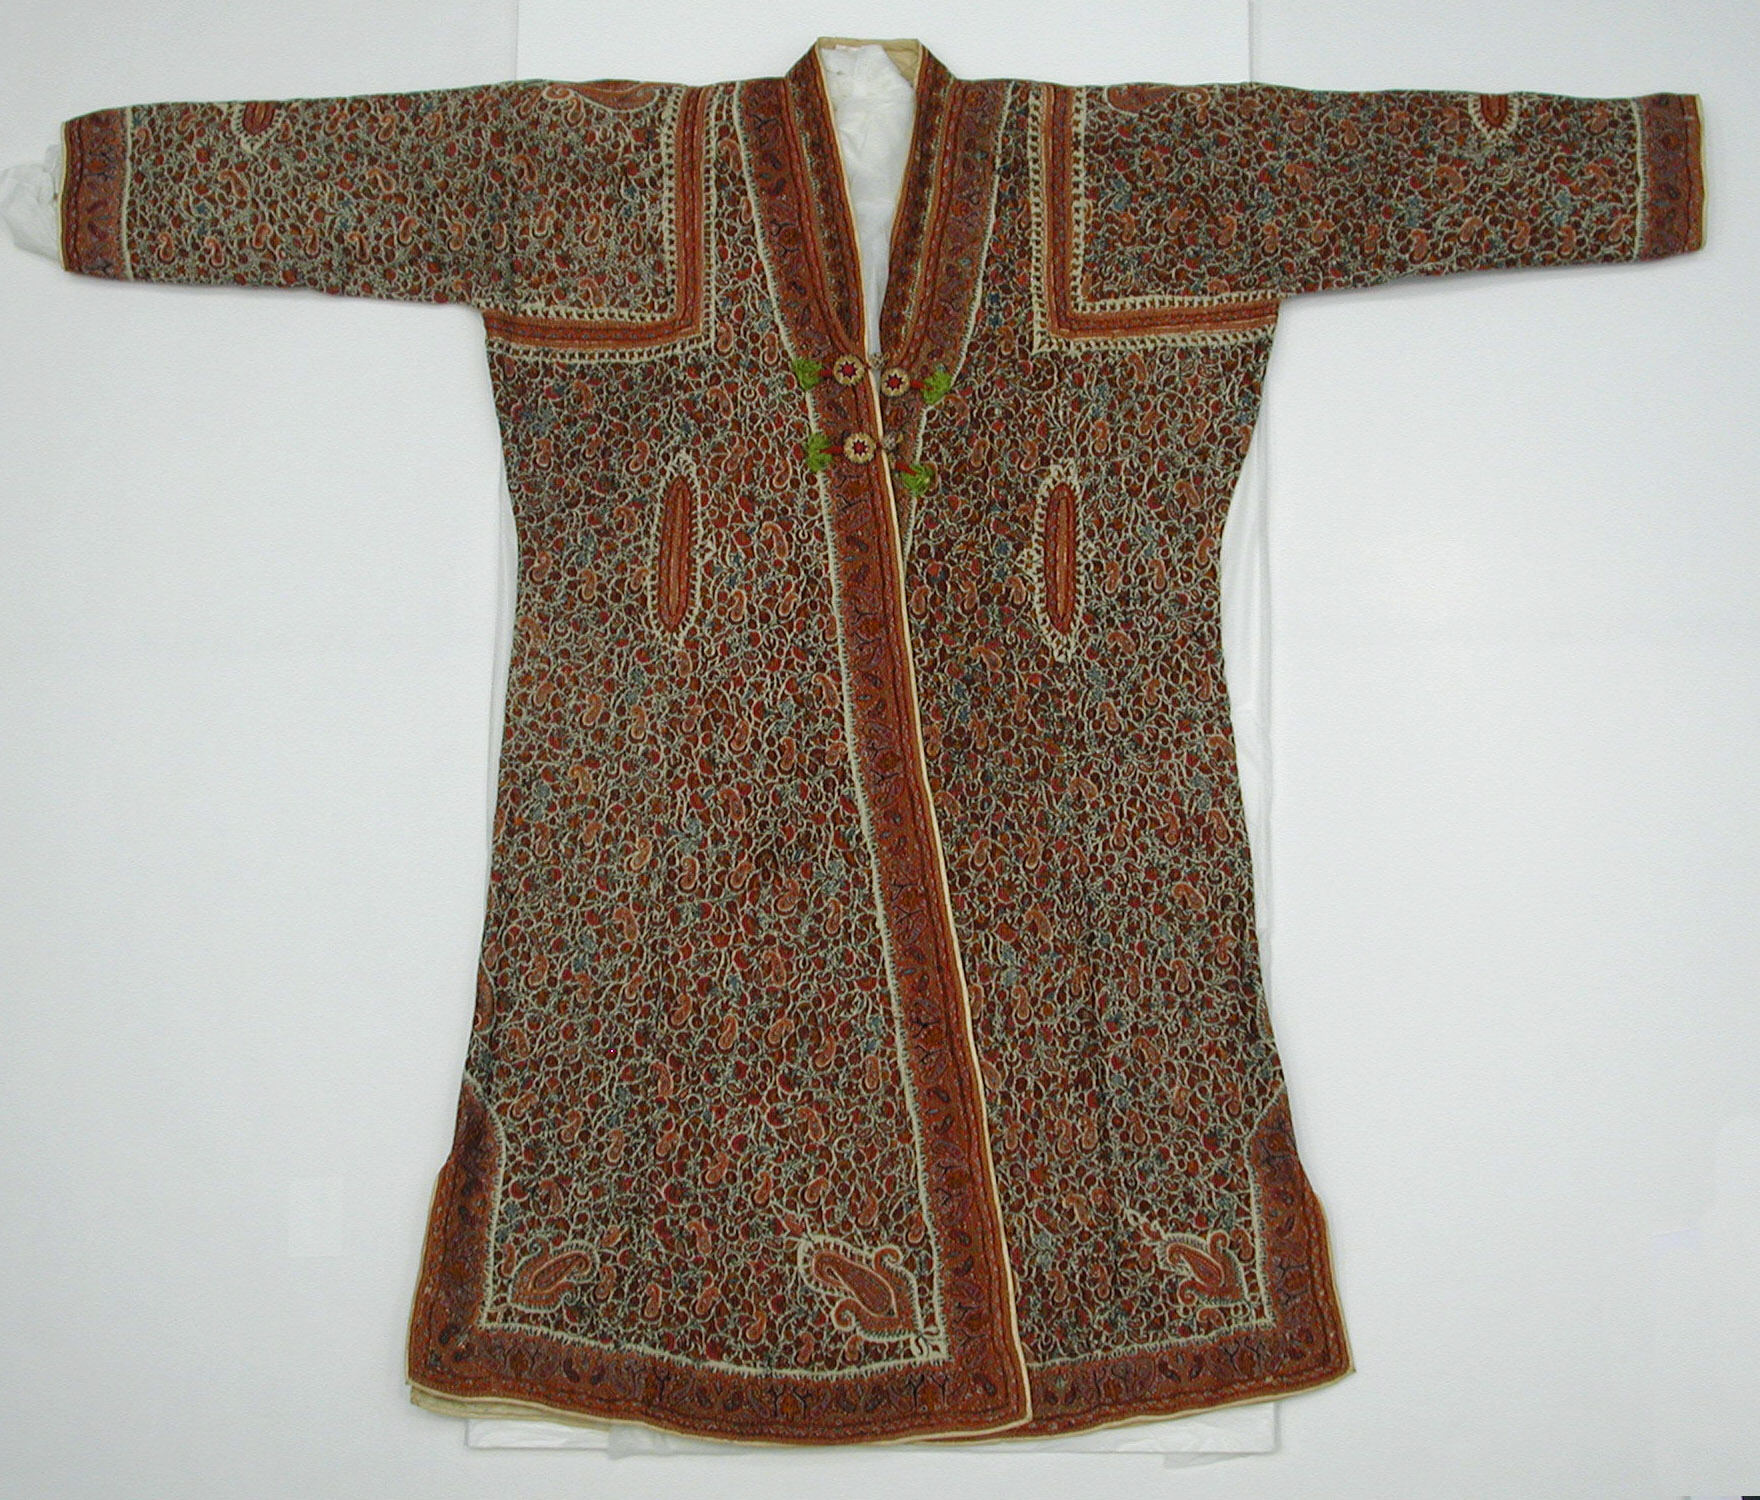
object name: coat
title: Coat (Choga)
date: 1834-1866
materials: wool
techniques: embroidery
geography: india